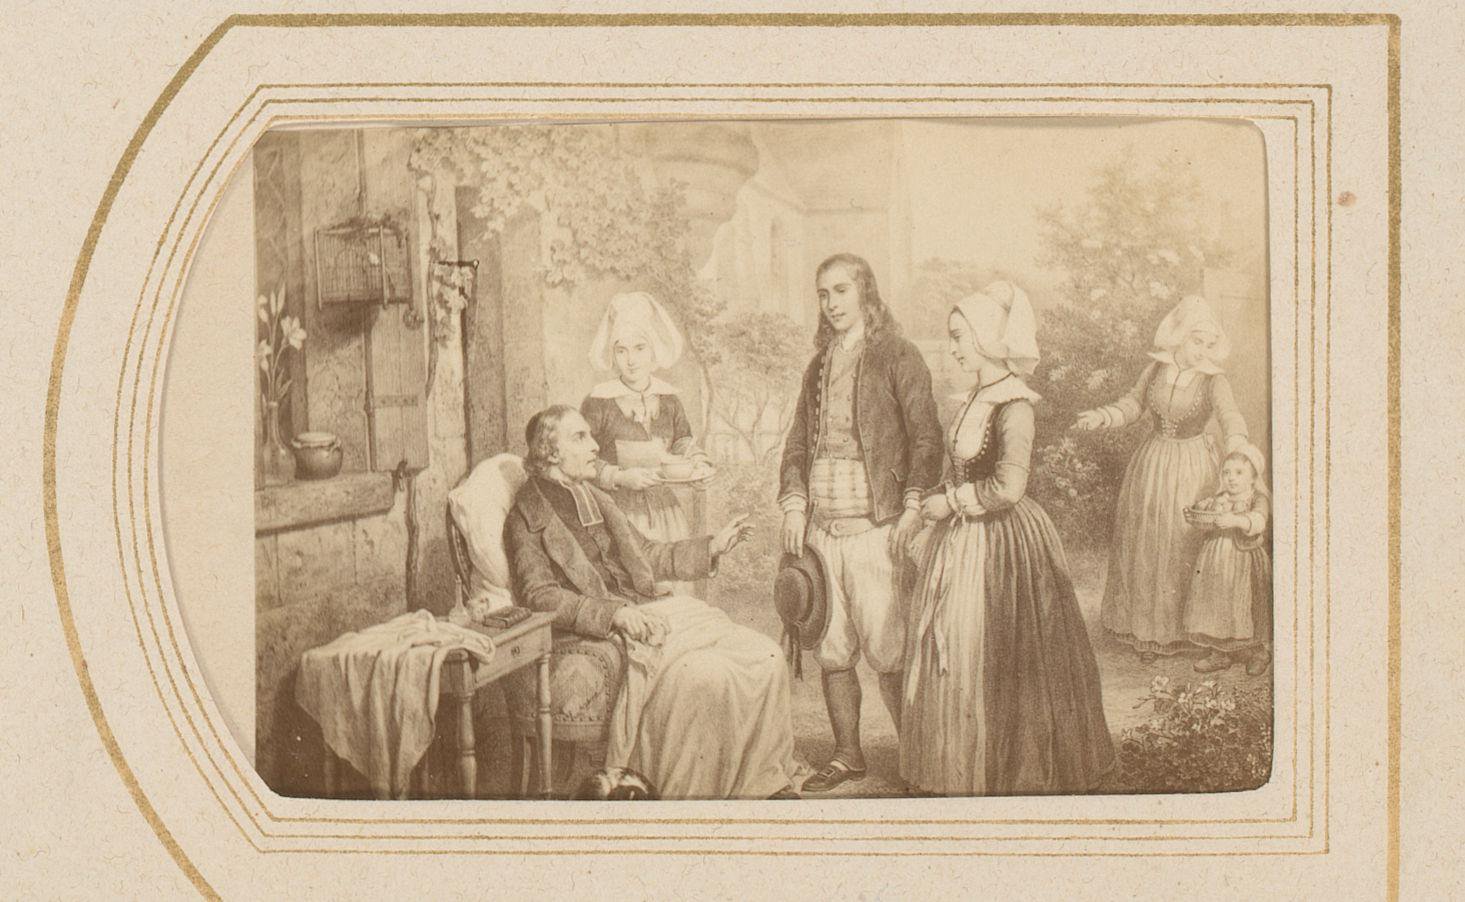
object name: reproduction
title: Fotoreproductie van La convalescance du pasteur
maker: Anonymous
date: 1870-1900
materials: cardboard, photographic support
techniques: albumen print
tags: garden, adult man, painting, drawing and the graphic arts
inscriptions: annotation: ‘Die Genesung’, inscription: ‘Grenier./ 3068./ La convalescance du pasteur/ (...)’